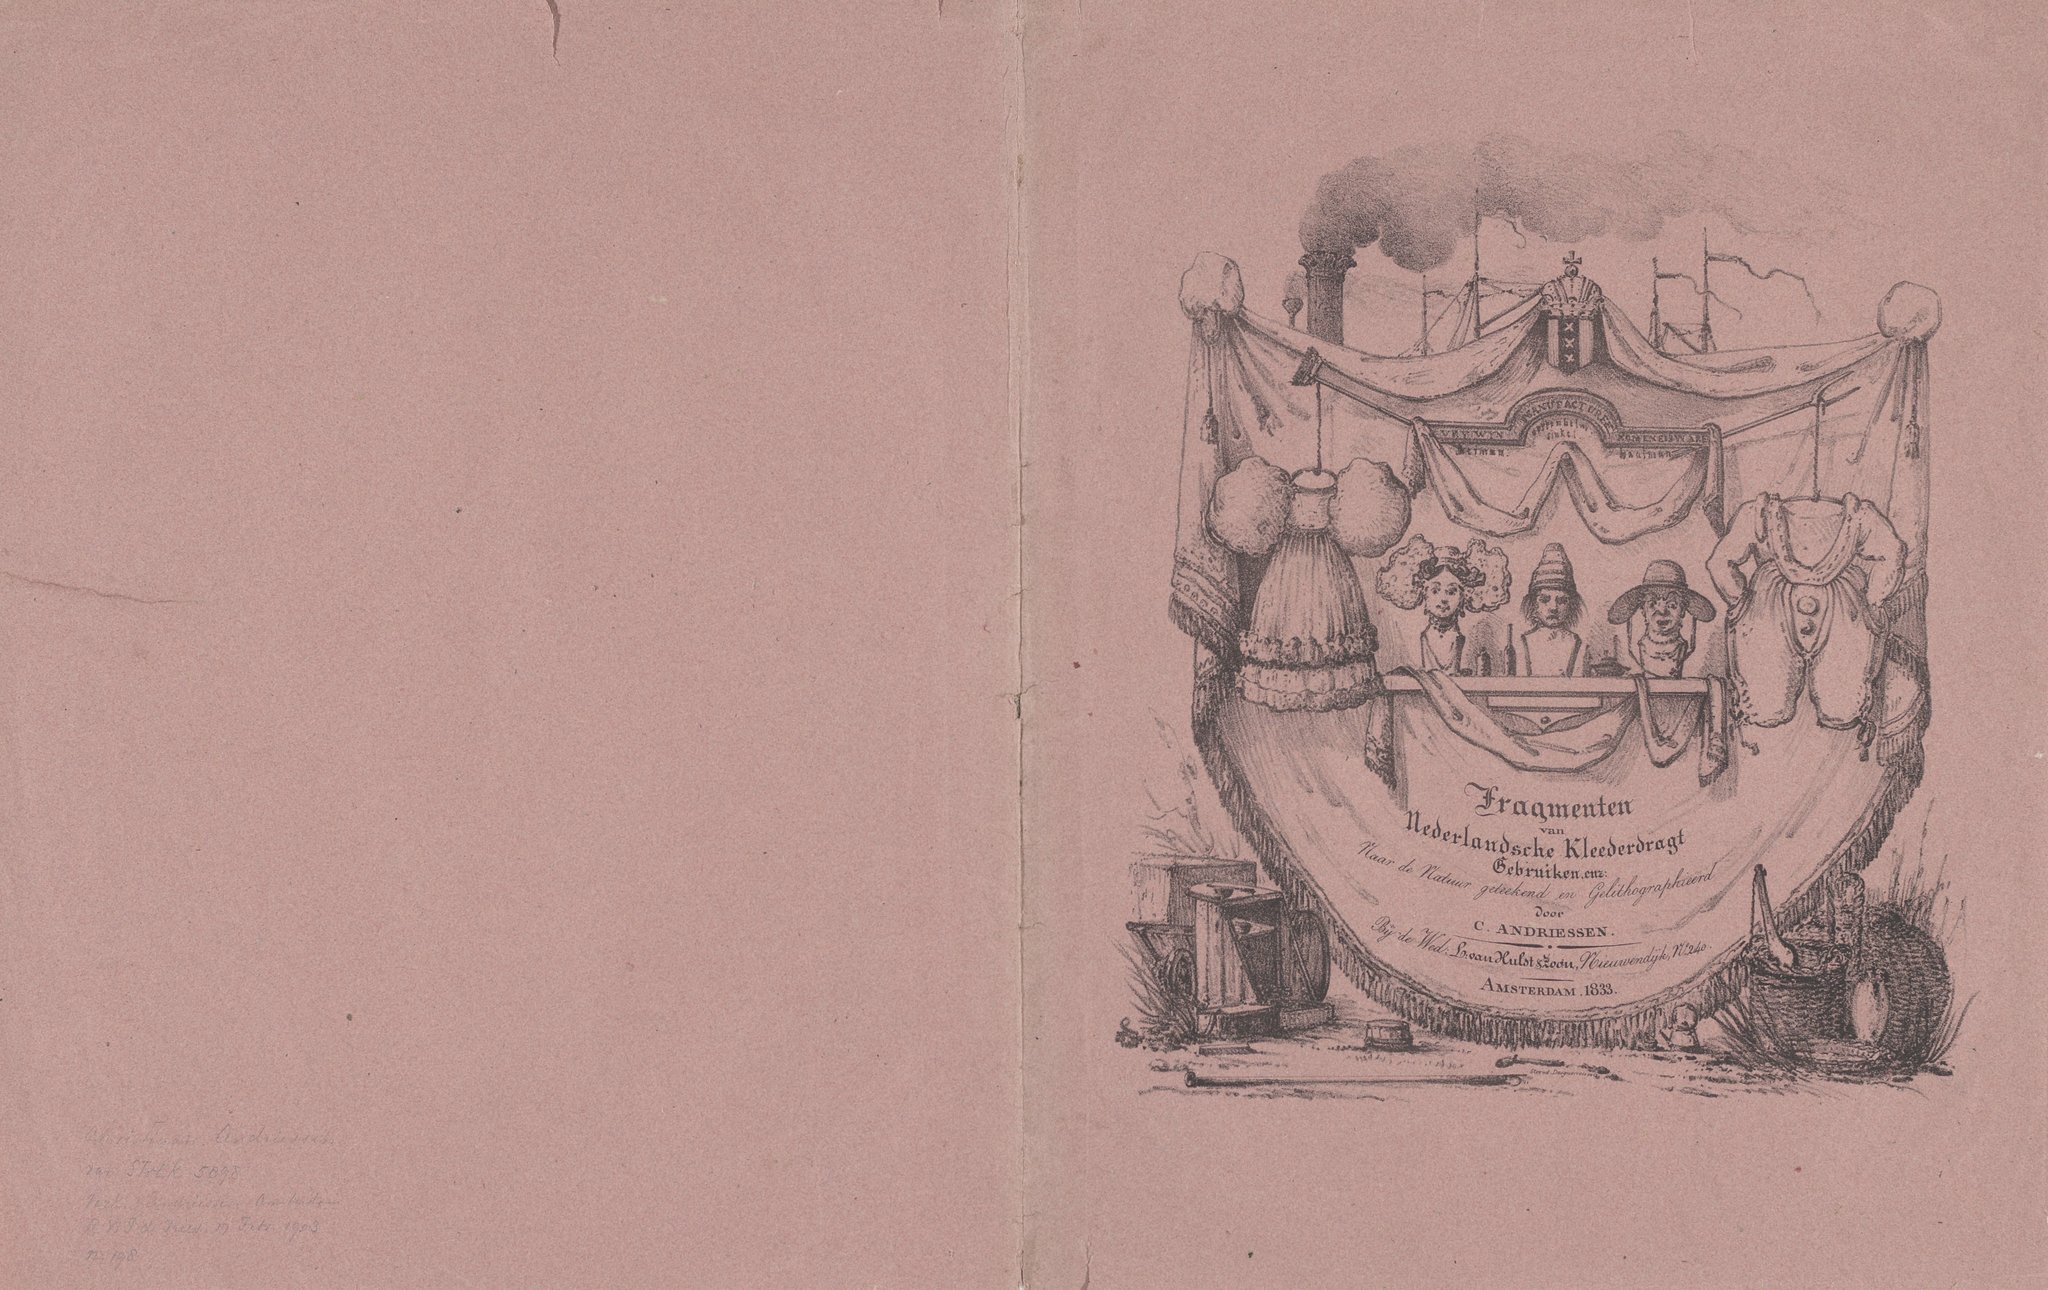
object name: print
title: Omslag Fragmenten van Nederlandsche kleederdragt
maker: christiaan andriessen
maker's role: draughtsman, print maker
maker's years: 1775-1846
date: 1833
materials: paper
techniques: lithograph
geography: netherlands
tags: curtain ~ stage, head-gear: cap, folk costume, regional costume, amsterdam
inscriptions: collector's mark: Lugt 2228, inscription: ‘Christiaan Andriessen / van Stolk 5898 / verk. Andriessen Amsterdam / R. W. P. de Vries 17 Febr 1903 / n. 198’, collector's mark: Lugt 2760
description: Voor een vaandel staan maskers op een plank, daarnaast hangen een jurk en een pak. Rondom het vaandel staan en liggen gebruiksvoorwerpen. Bovenin het vaandel het wapen van Amsterdam. Onderdeel van een serie van zes bladen met figuurstudies van Nederlandse klederdrachten, straatfiguren en gebuiken, 1833.